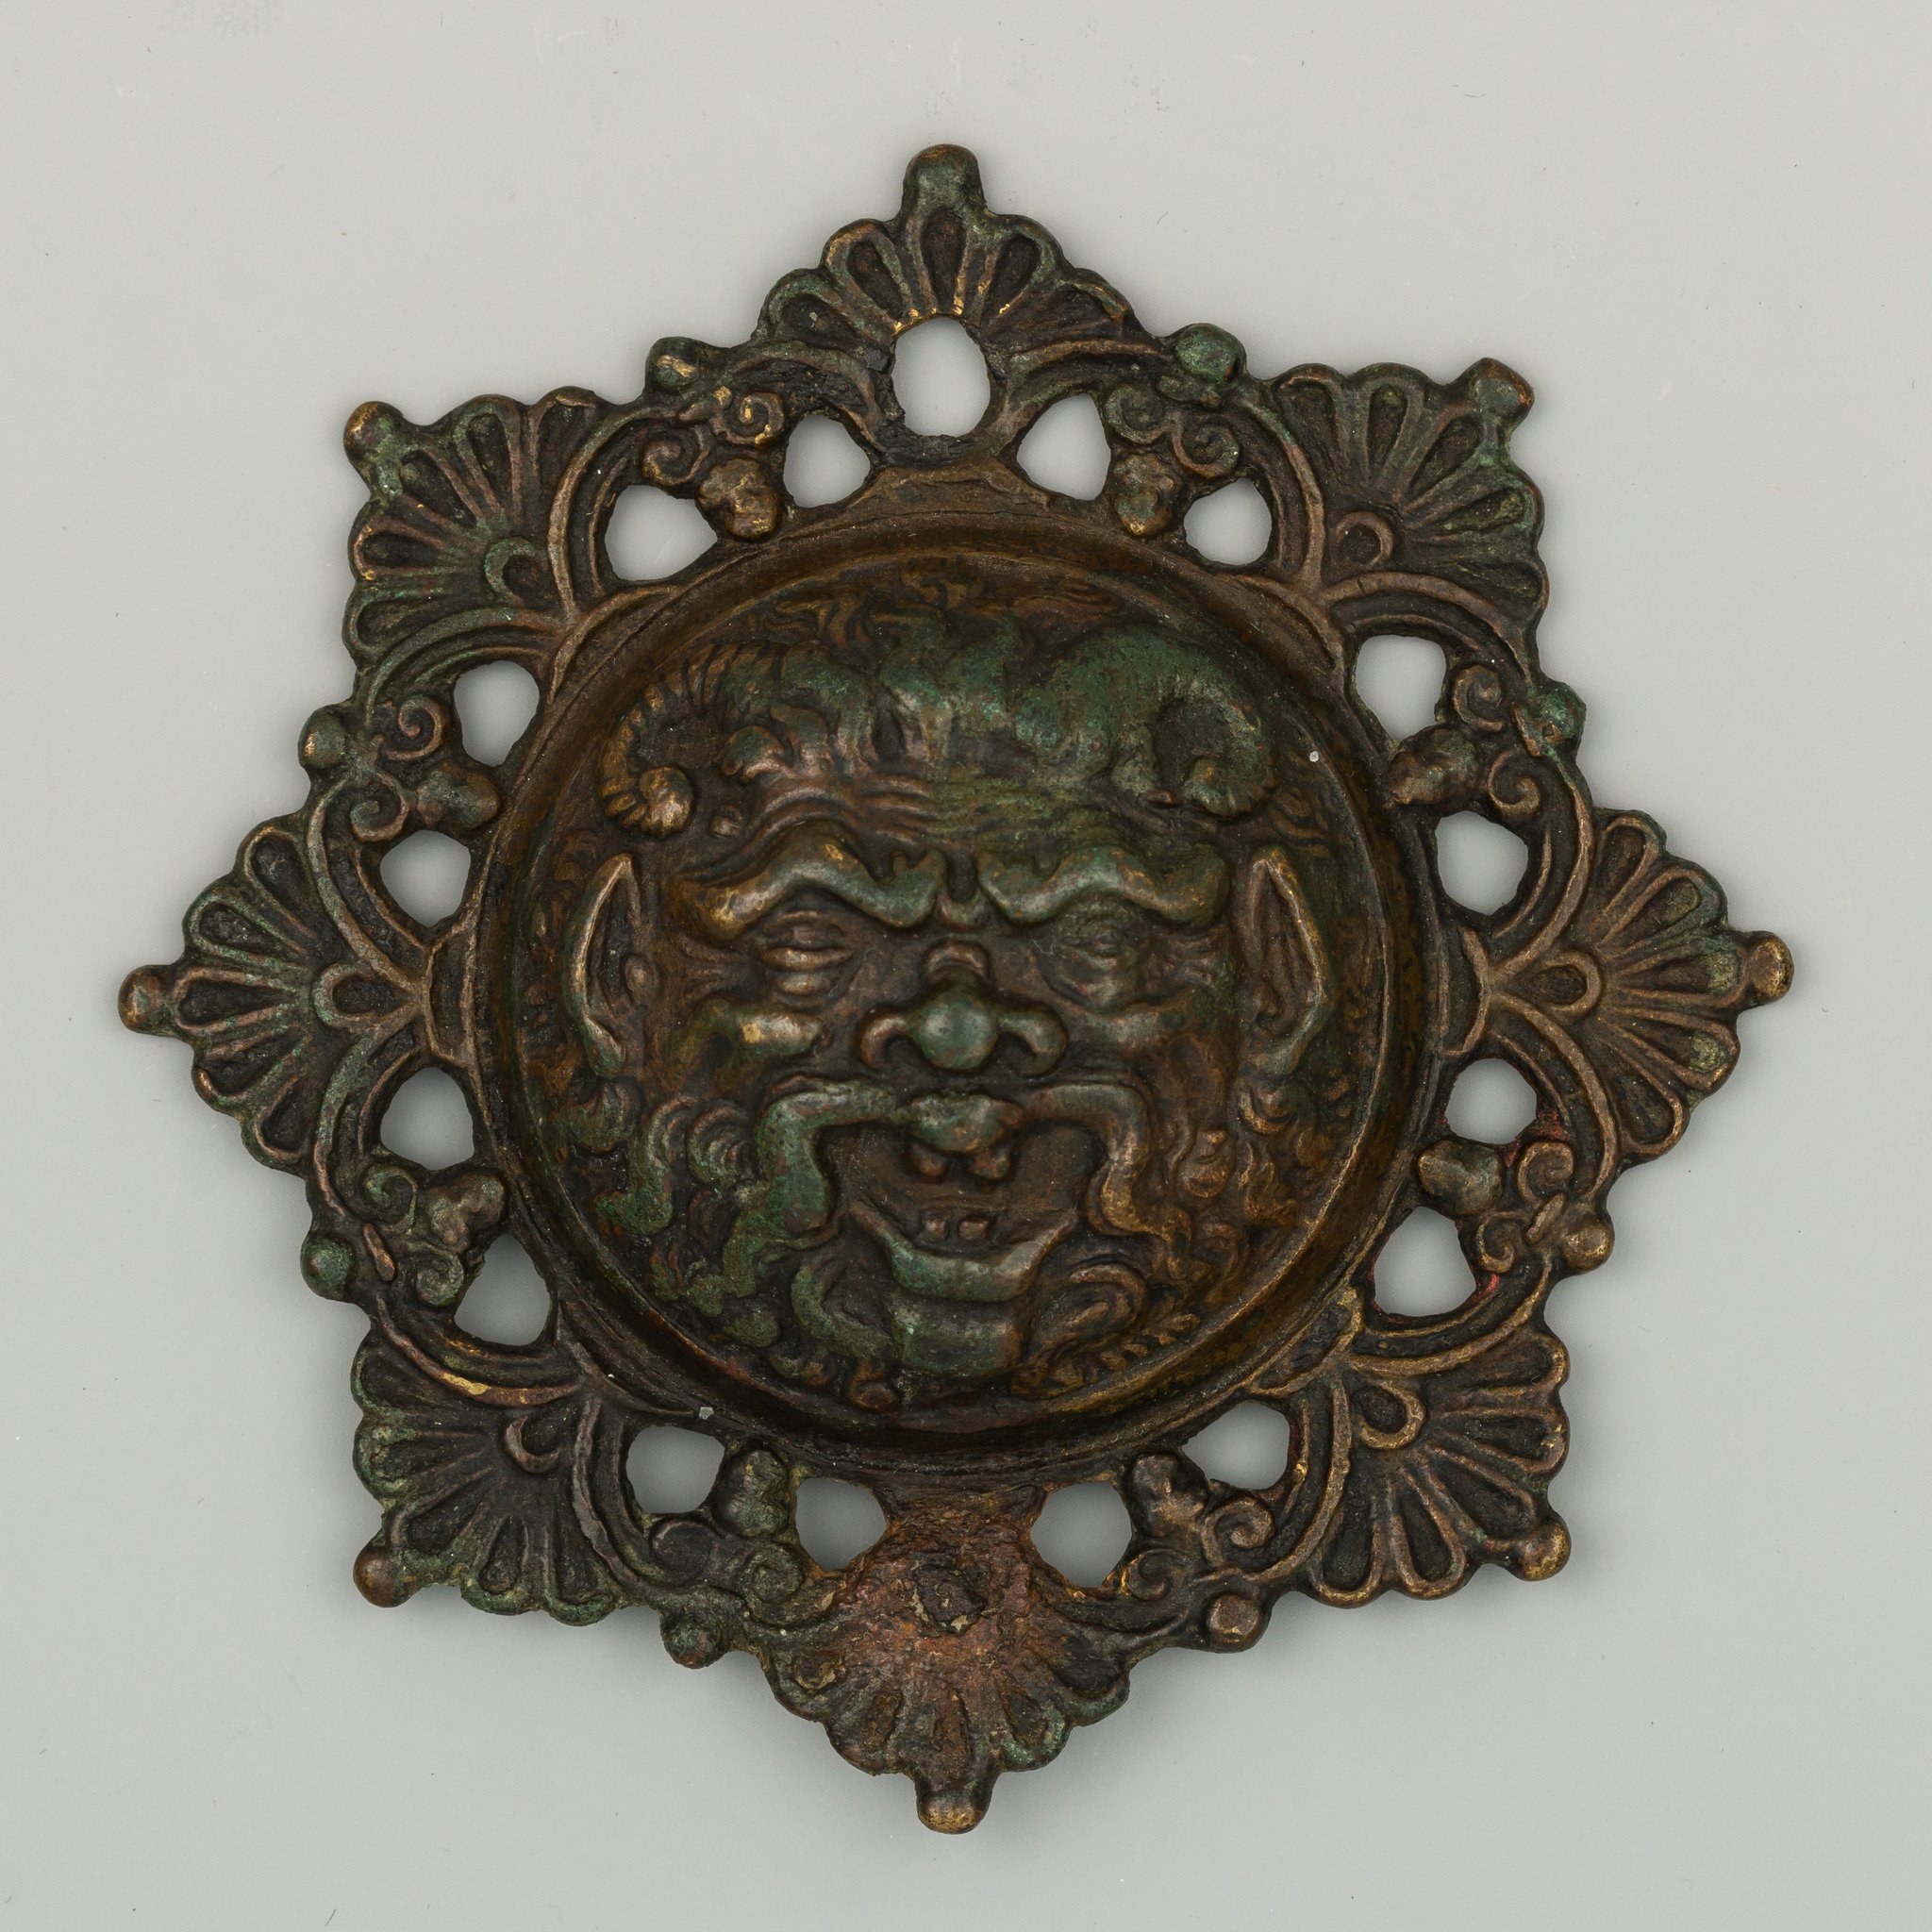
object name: bit bos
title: Bit Boss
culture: dutch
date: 1601-1650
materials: copper alloy, iron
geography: netherlands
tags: faces